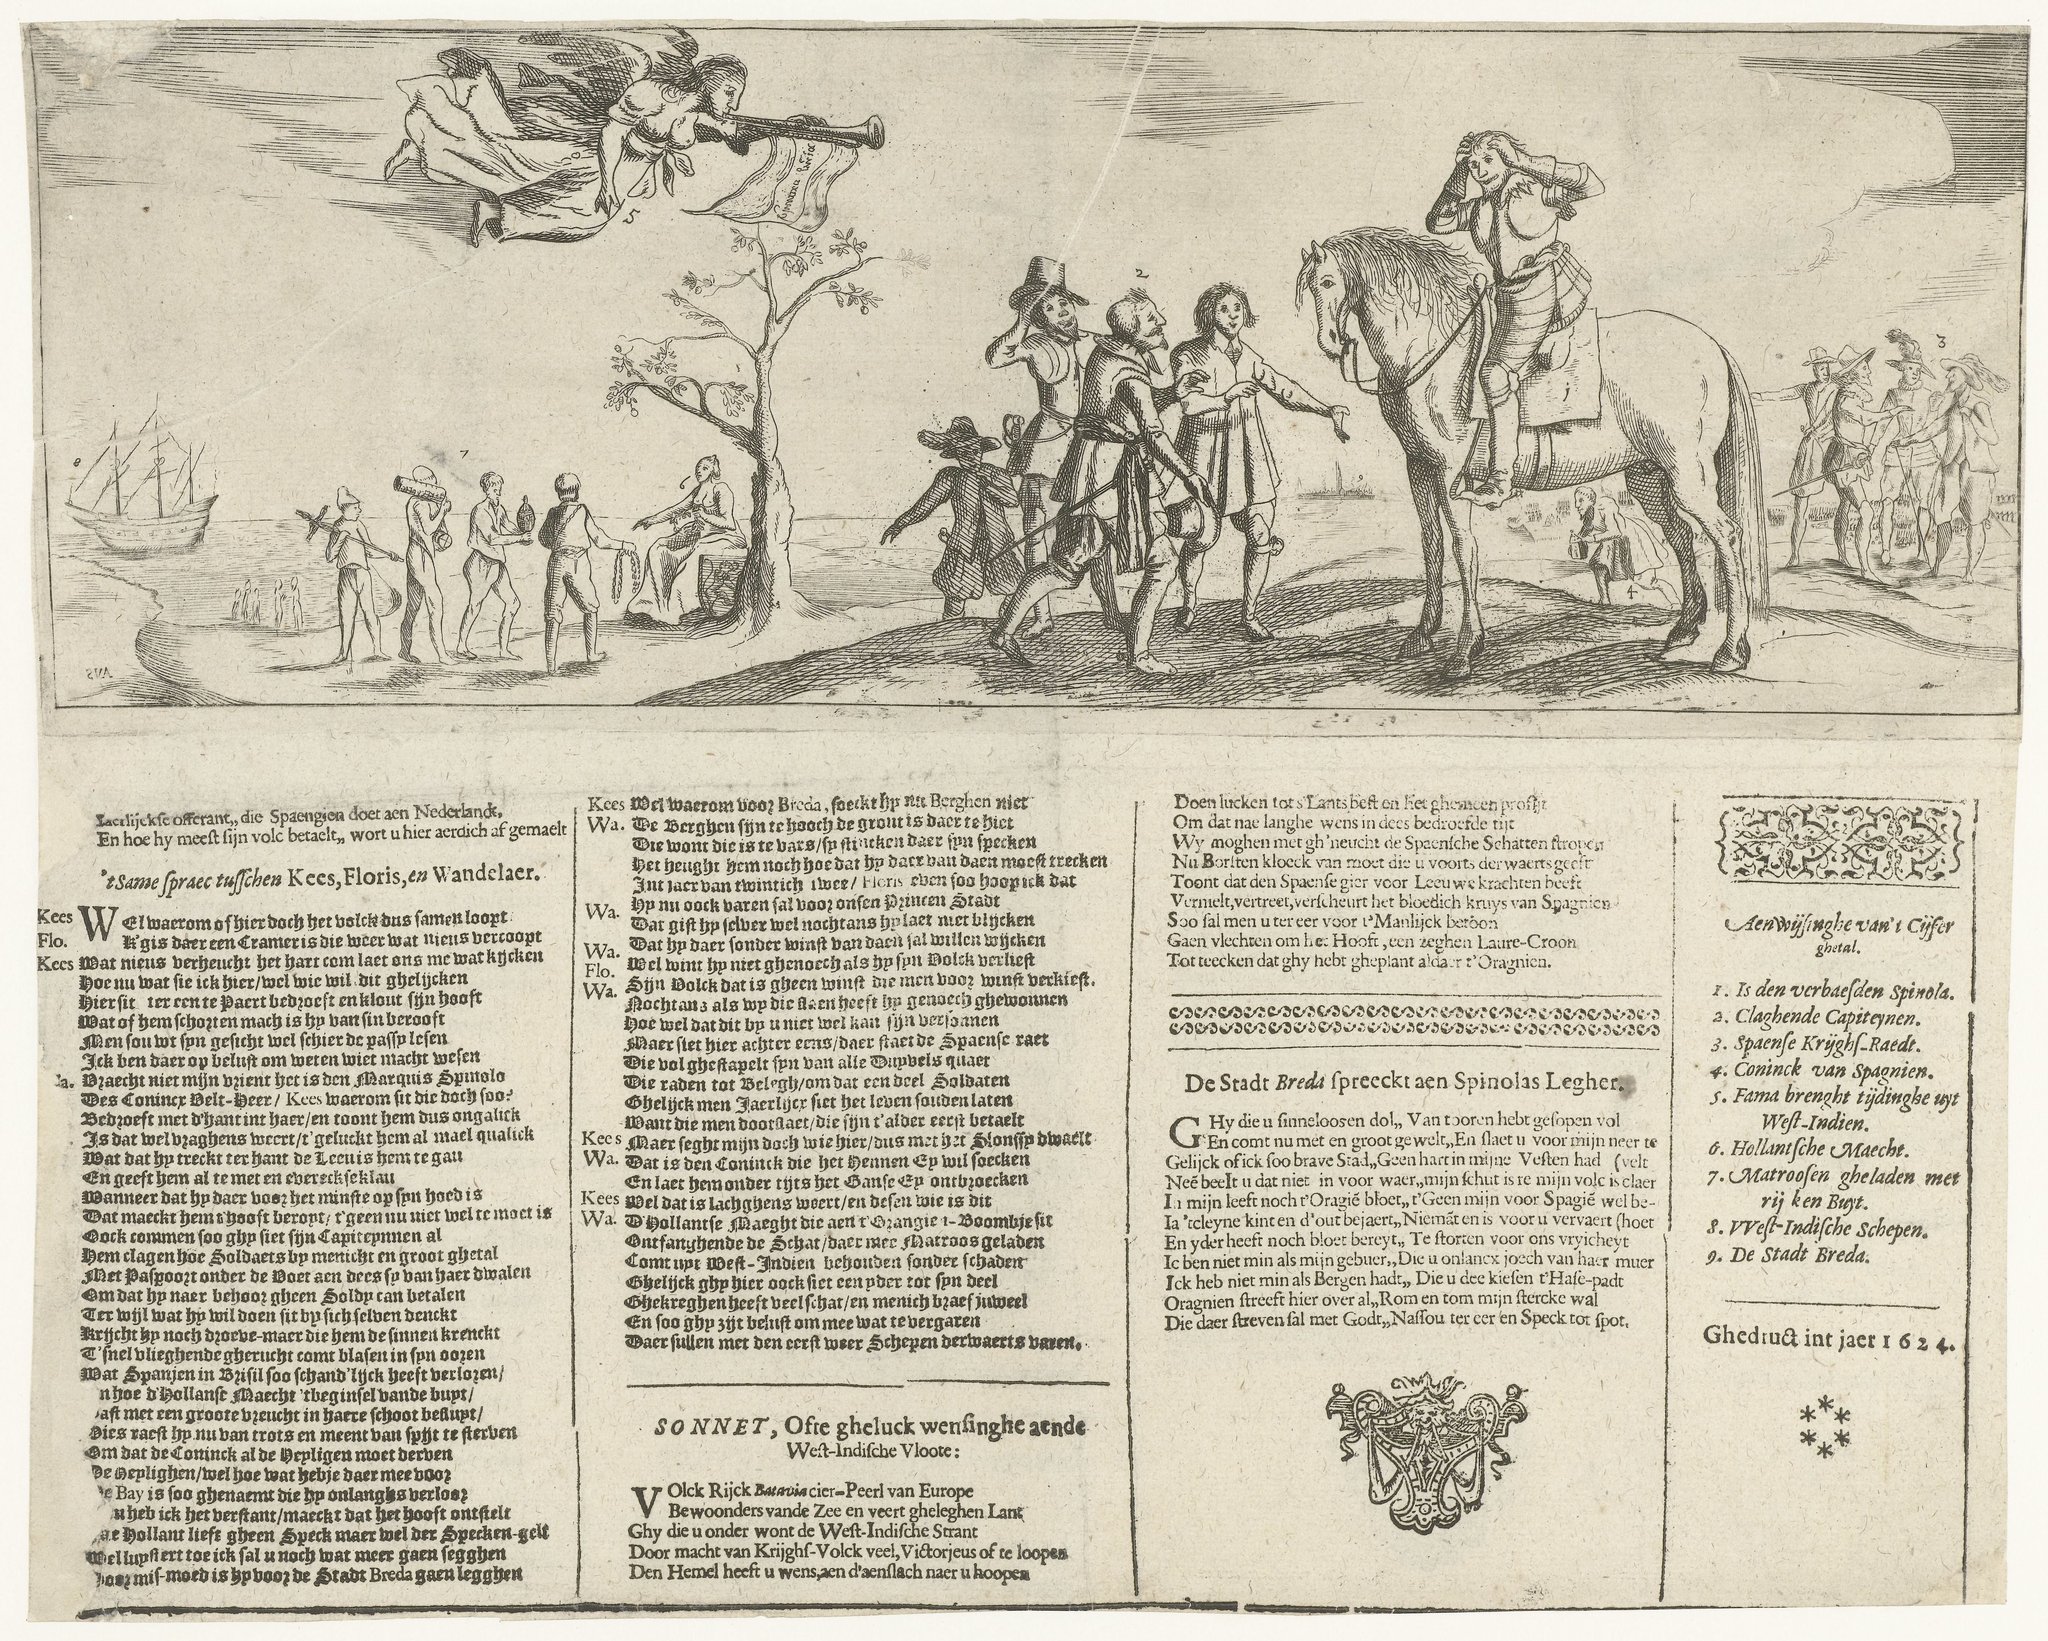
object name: print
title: Spotprent op het geldtekort van Spinola, 1624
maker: monogrammist avs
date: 1624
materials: paper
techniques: engraving, etching, letterpress printing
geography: northern netherlands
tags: fame; 'fama', 'fama buona', 'fama chiara' (ripa), political caricatures and satires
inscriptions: date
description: Spotprent op het geldtekort van Spinola, 1624. Spinola te paard zit met de handen in het haar omdat hij geen geld heeft om de soldij van zijn soldaten te betalen. De Faam brengt hem het nieuws van de verovering van Salvador in Brazilië door de Hollanders (10 mei 1624). Links brengen de matrozen van schepen uit West-Indië de rijke buit naar de Nederlandse Maagd. In de verte de stad Breda dat door Spinola wordt belegerd, rechts de Spaanse krijgsraad. Op het blad onder de plaat vier kolommen tekst en het Nederlands met een samenspraak, twee verzen en de legenda 1-9.